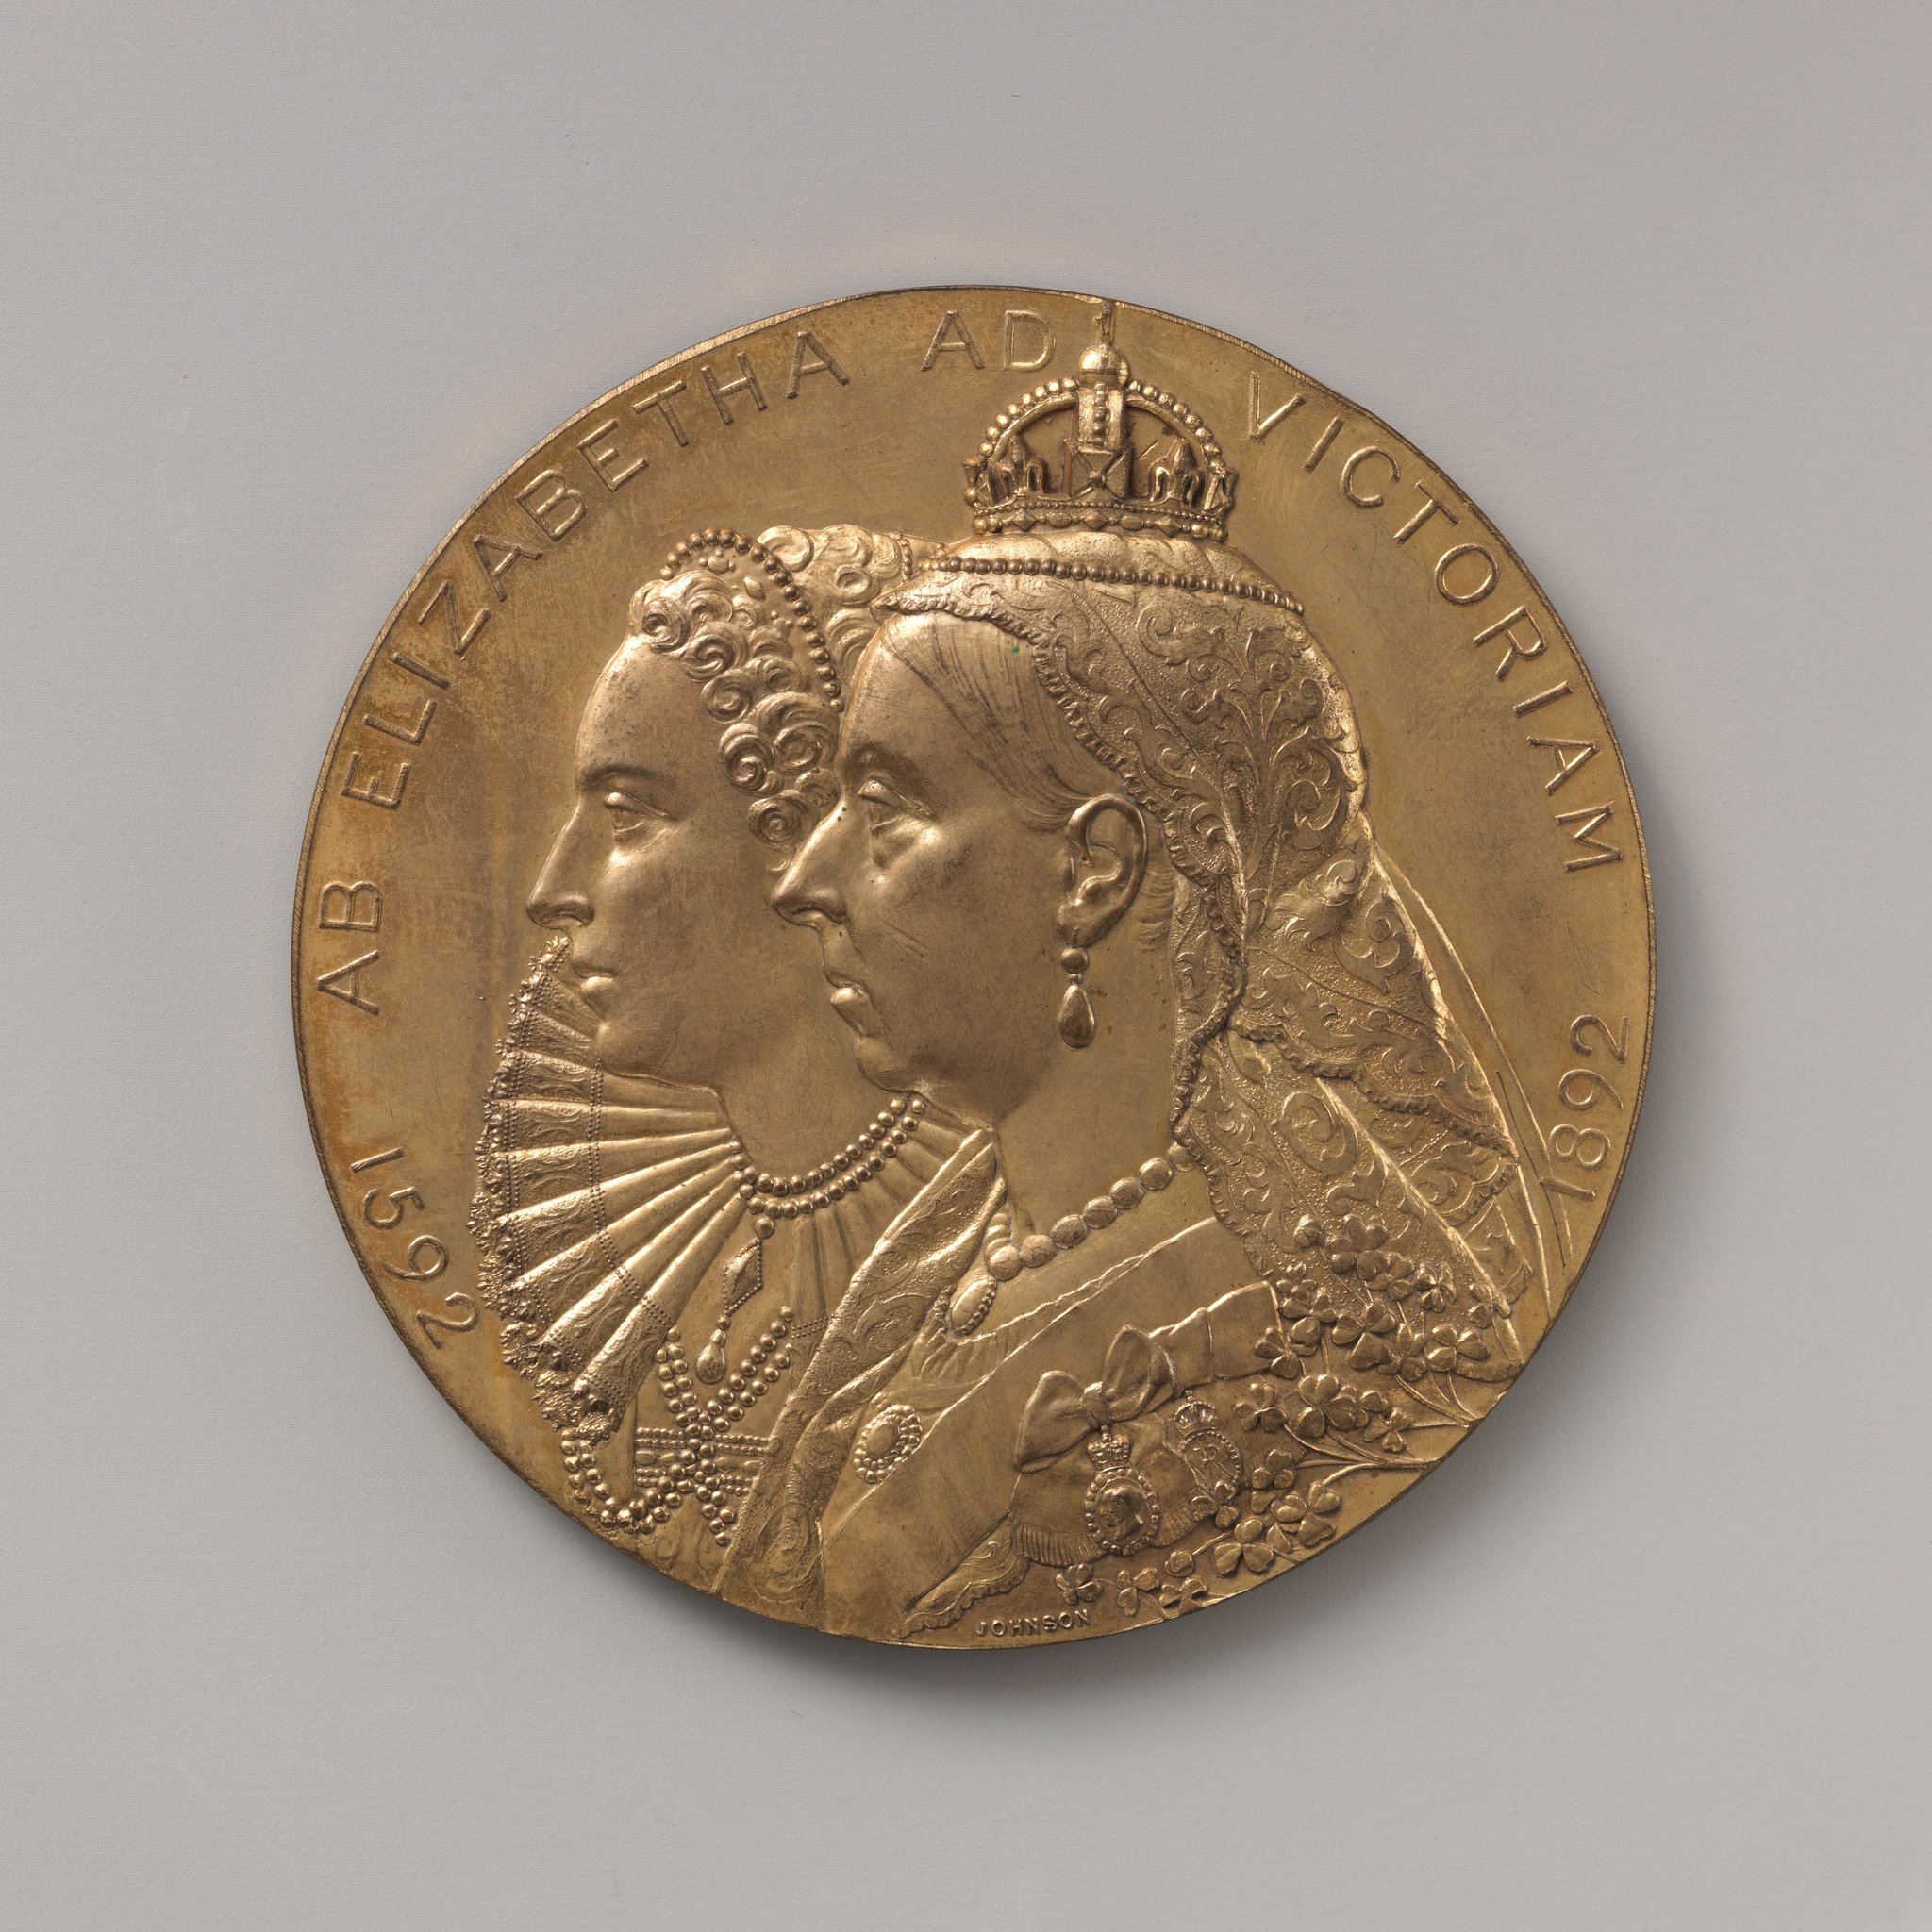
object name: medal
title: Commemorating the Tercentenary of Trinity College, Dublin in 1892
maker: edmond johnson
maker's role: artist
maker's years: 1850-1950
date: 1892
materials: gilt bronze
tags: profiles,women,harps,lions